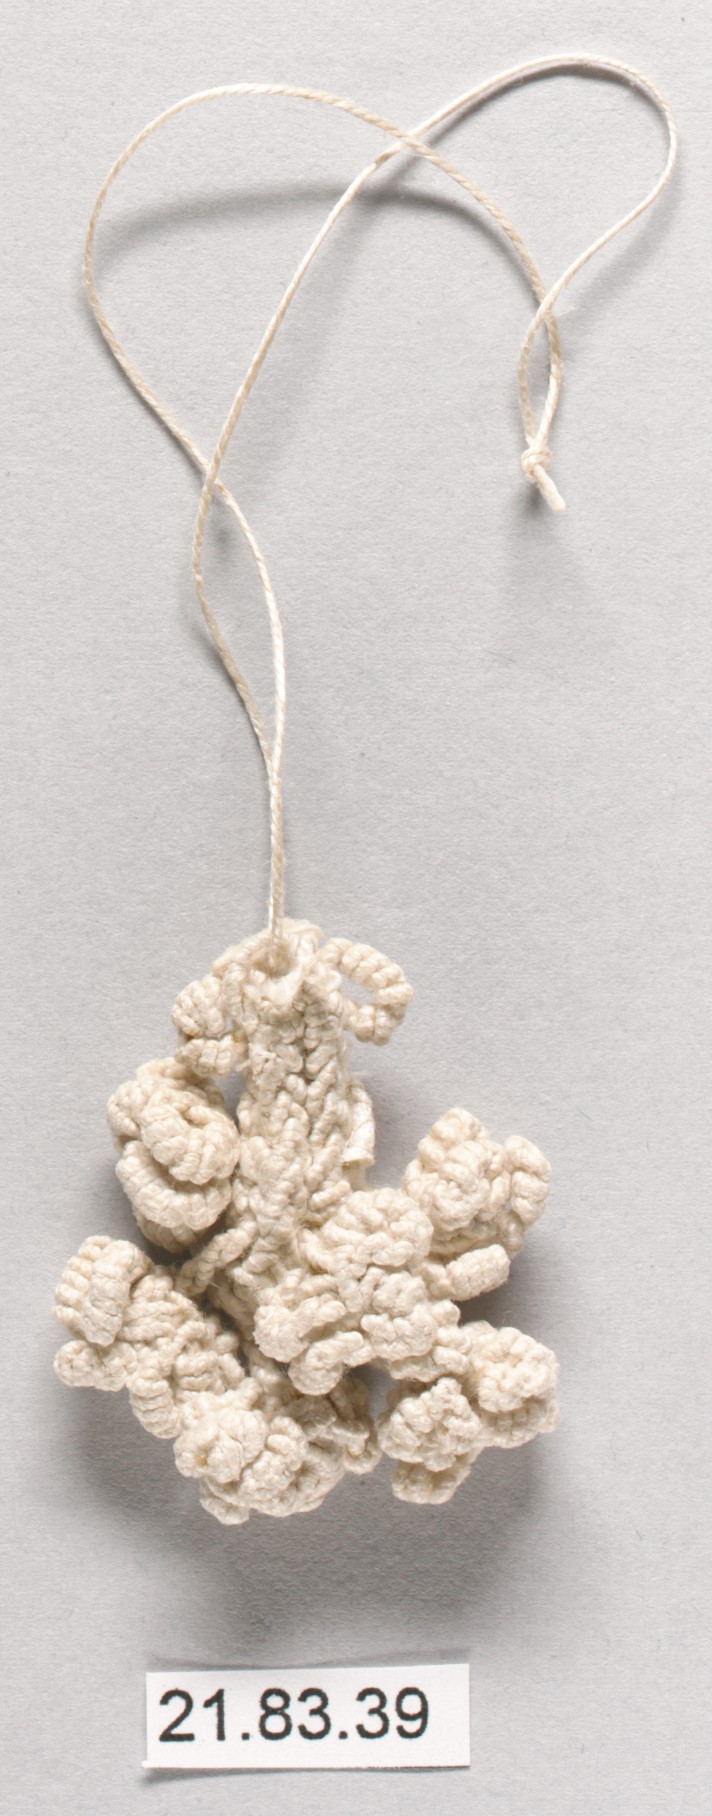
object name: tassel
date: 1601-1700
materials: linen